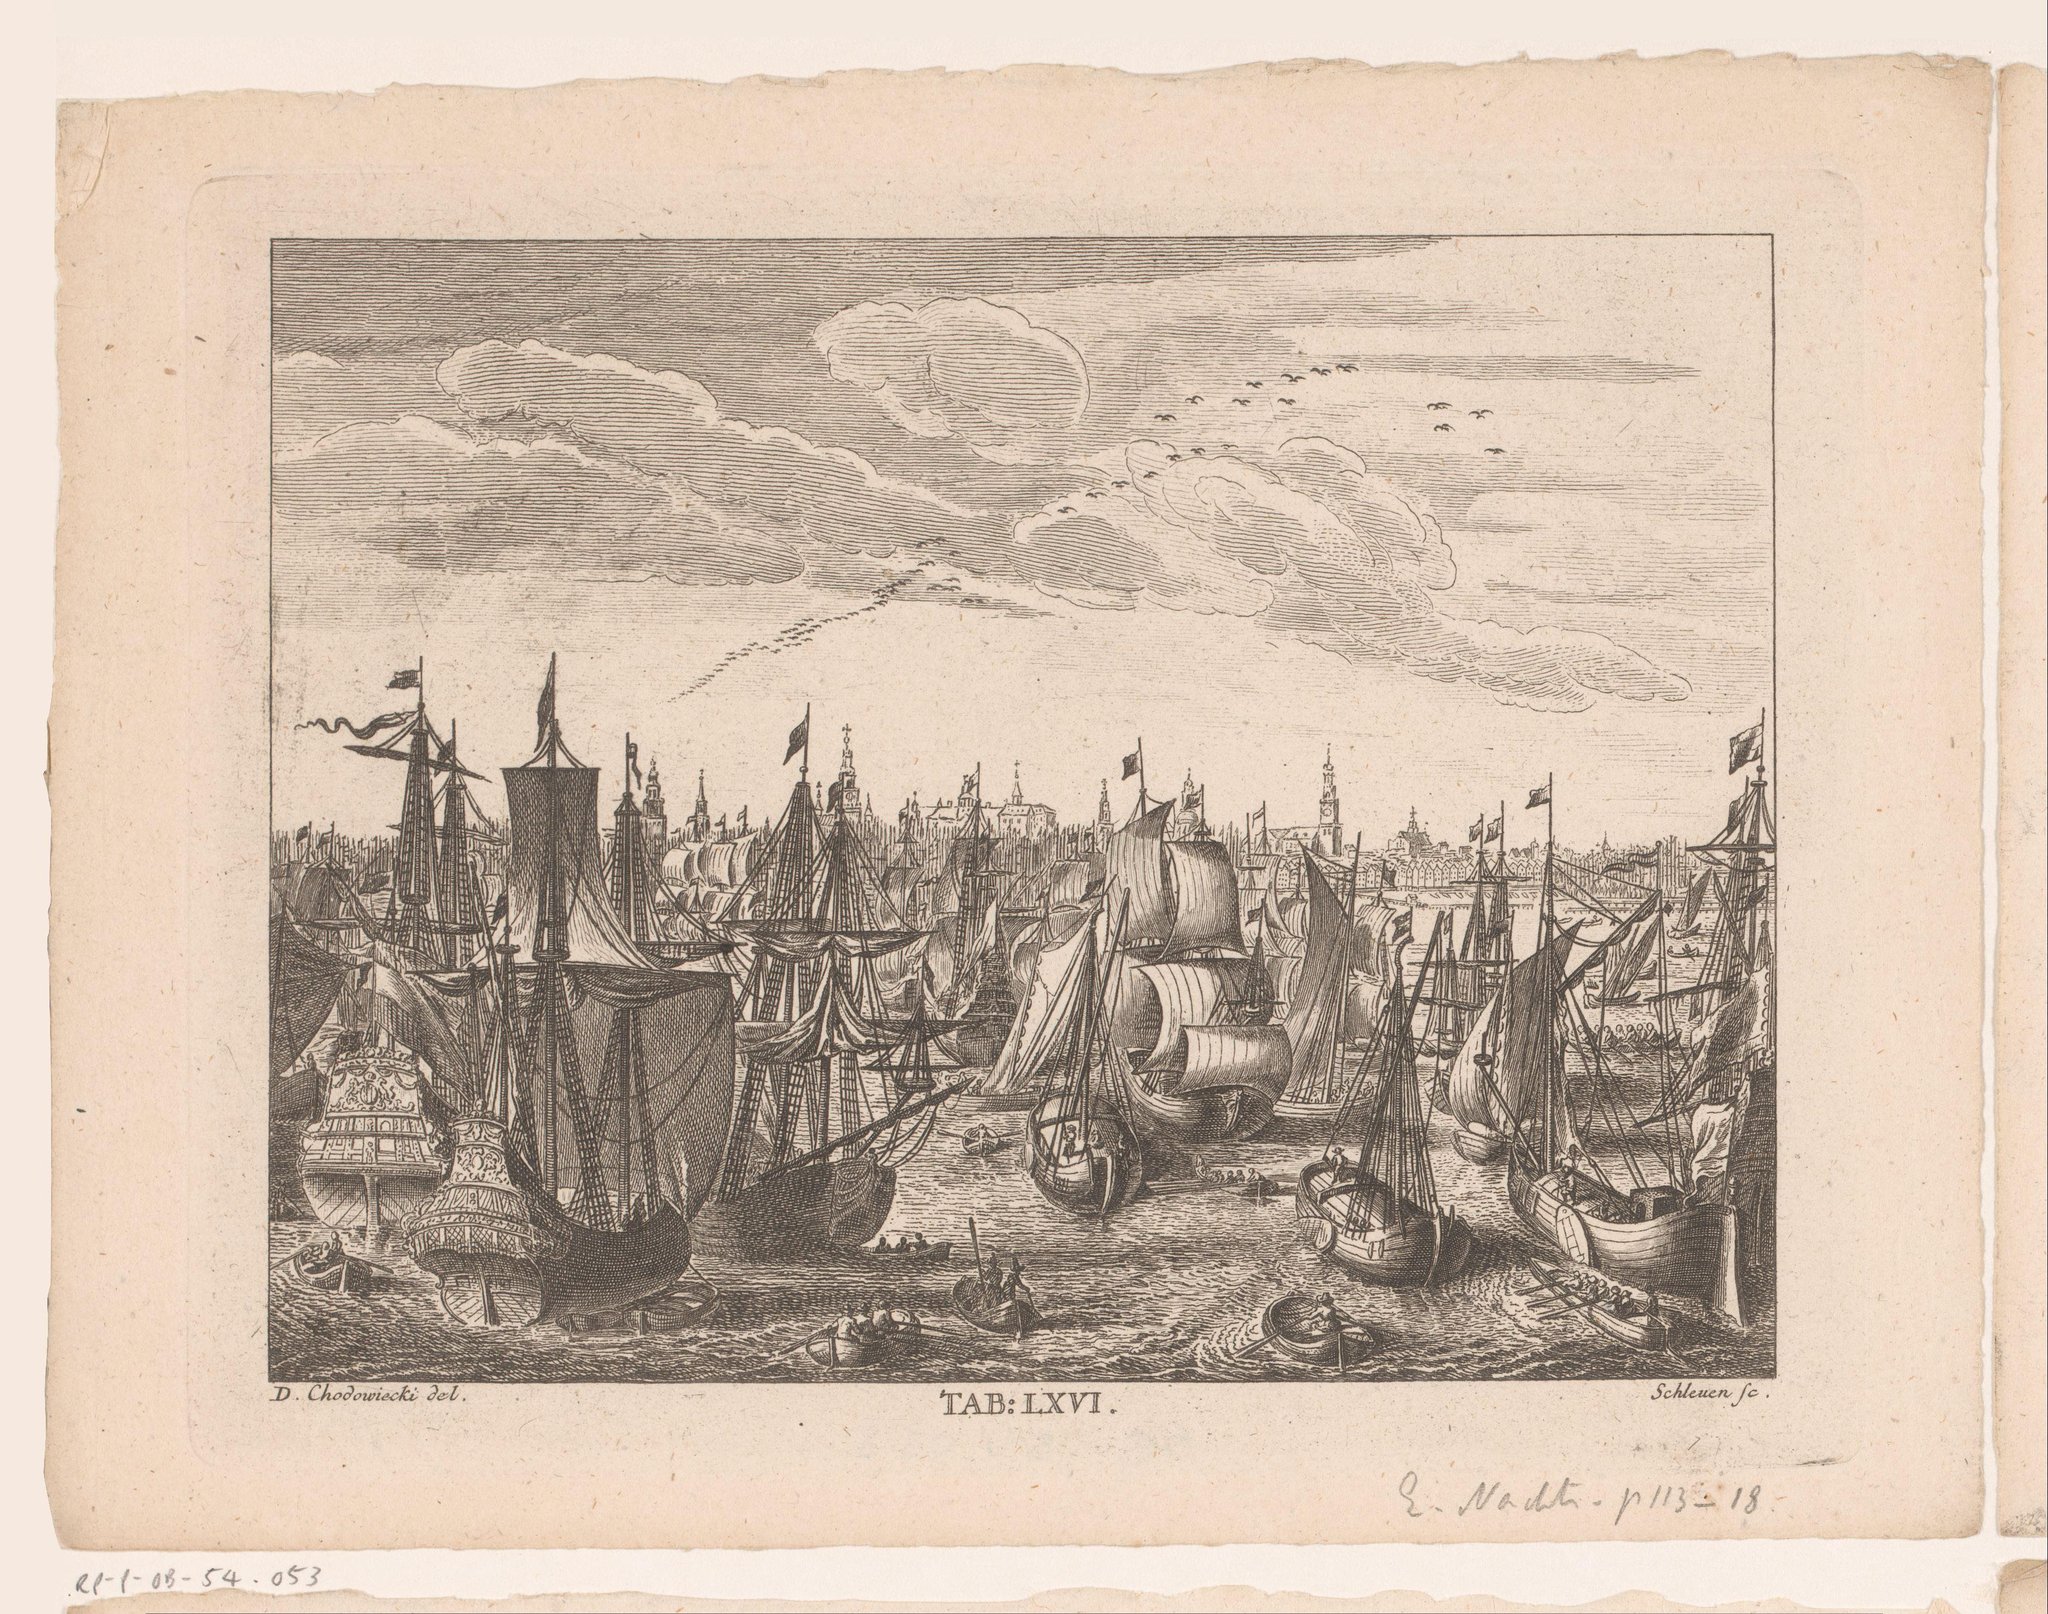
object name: print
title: Gezicht op Amsterdam vanaf het IJ met schepen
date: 1765-1806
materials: paper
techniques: etching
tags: harbour, amsterdam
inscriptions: collector's mark: Lugt 2228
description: Prent ook gebruikt in: Allgemeine deutsche Bibliothek. Berlijn en Stettin: Friedrich Nicolai, 1765-1806.